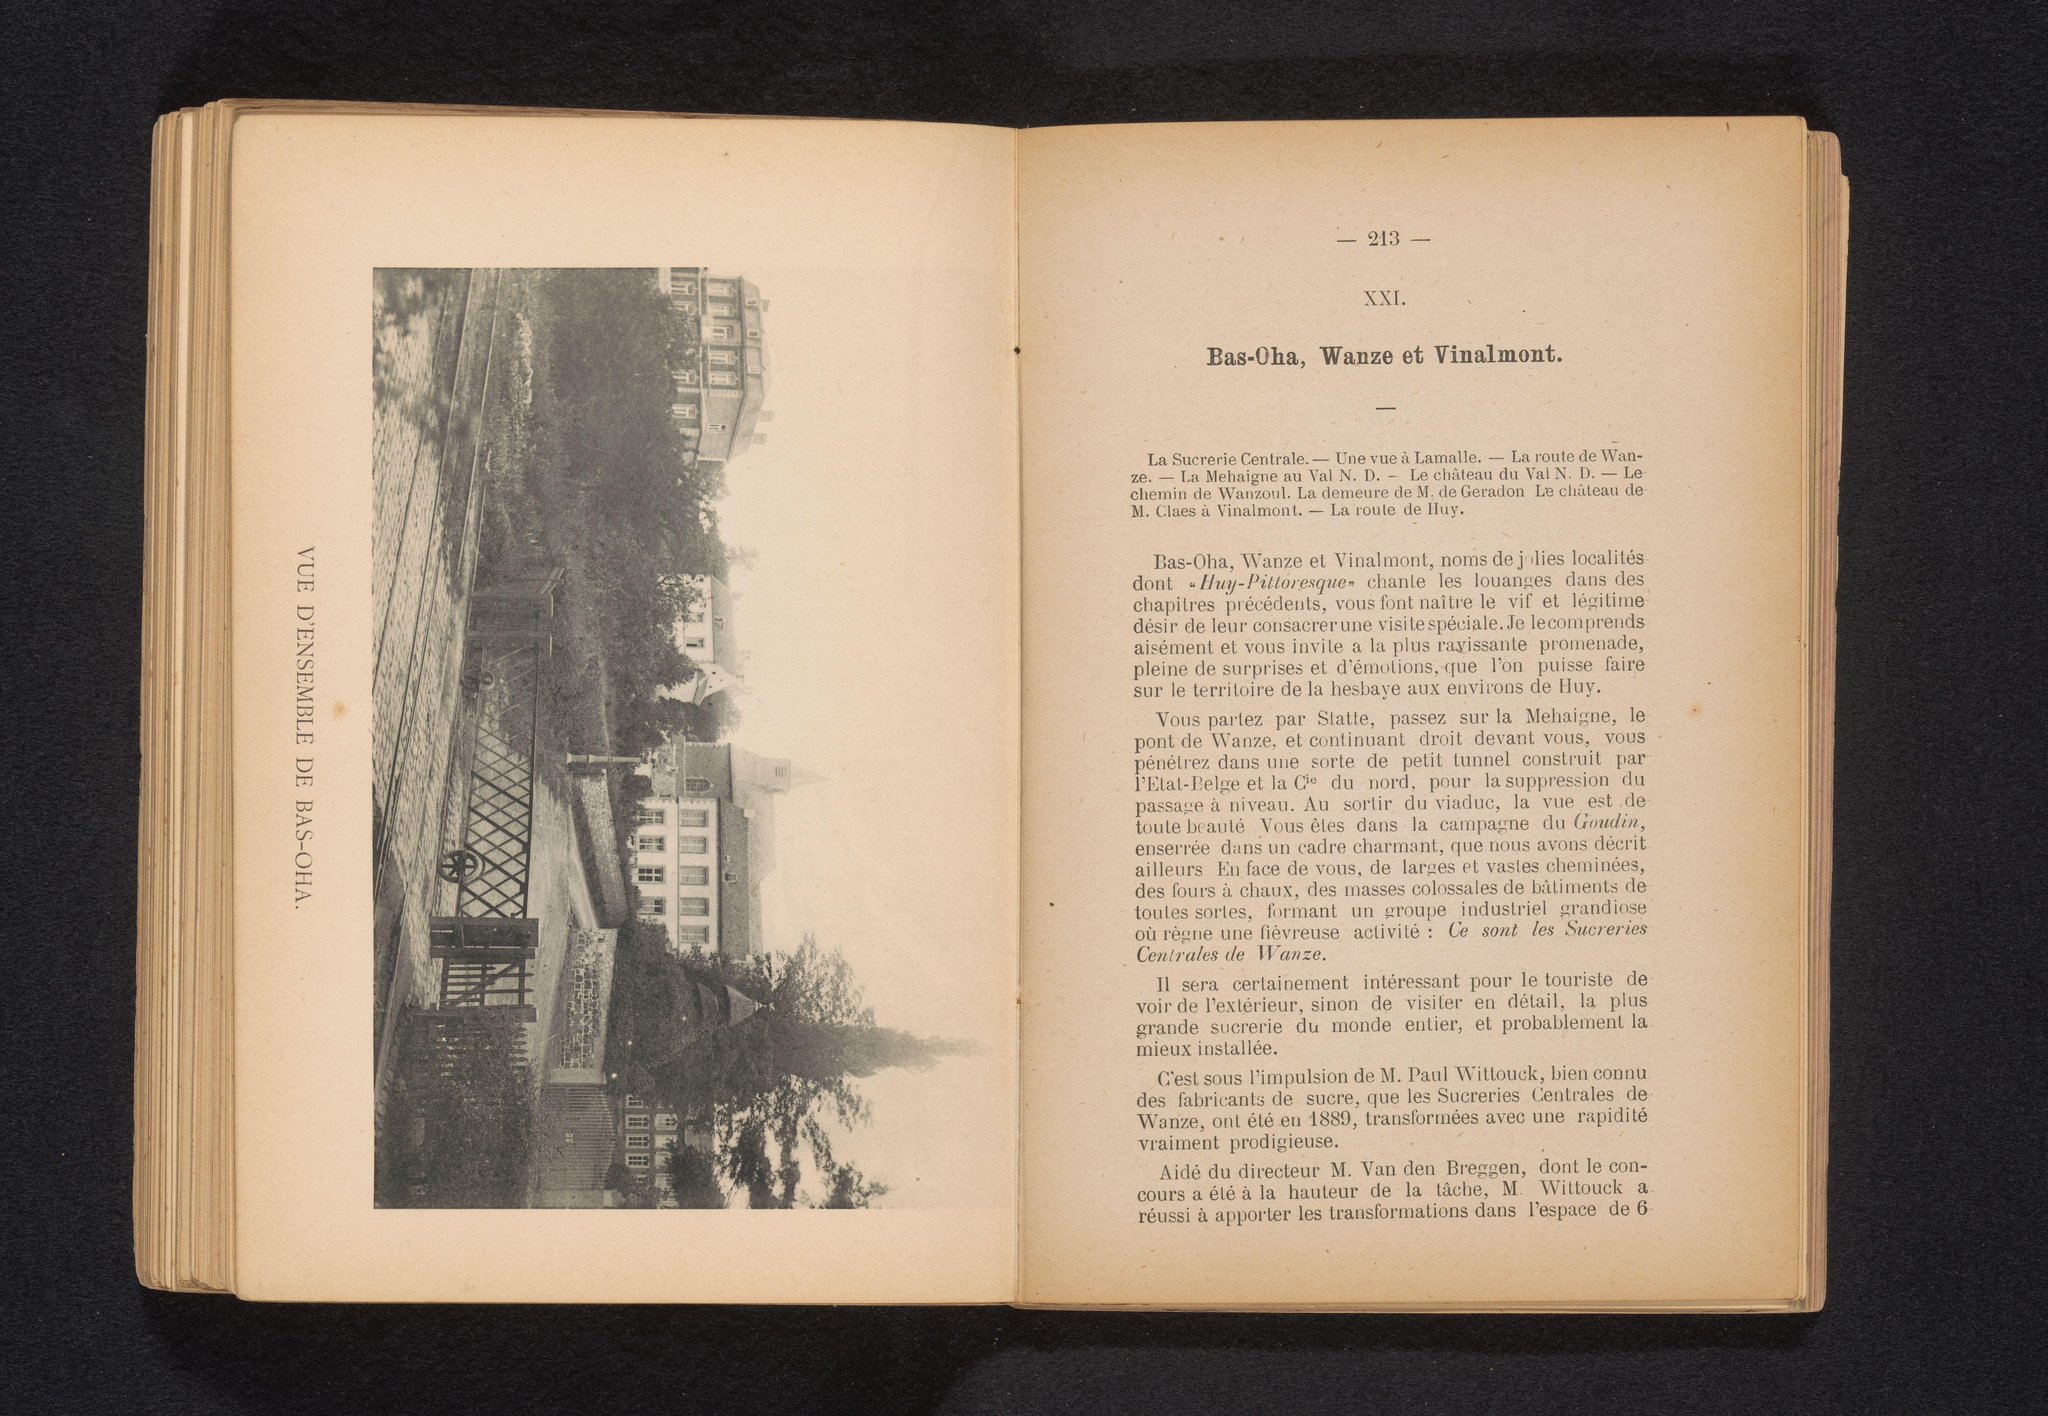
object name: photomechanical print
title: Vue d'ensemble de Bas-Oha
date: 1885-1890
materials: paper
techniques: photograph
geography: bas-oha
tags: city-view in general; 'veduta'